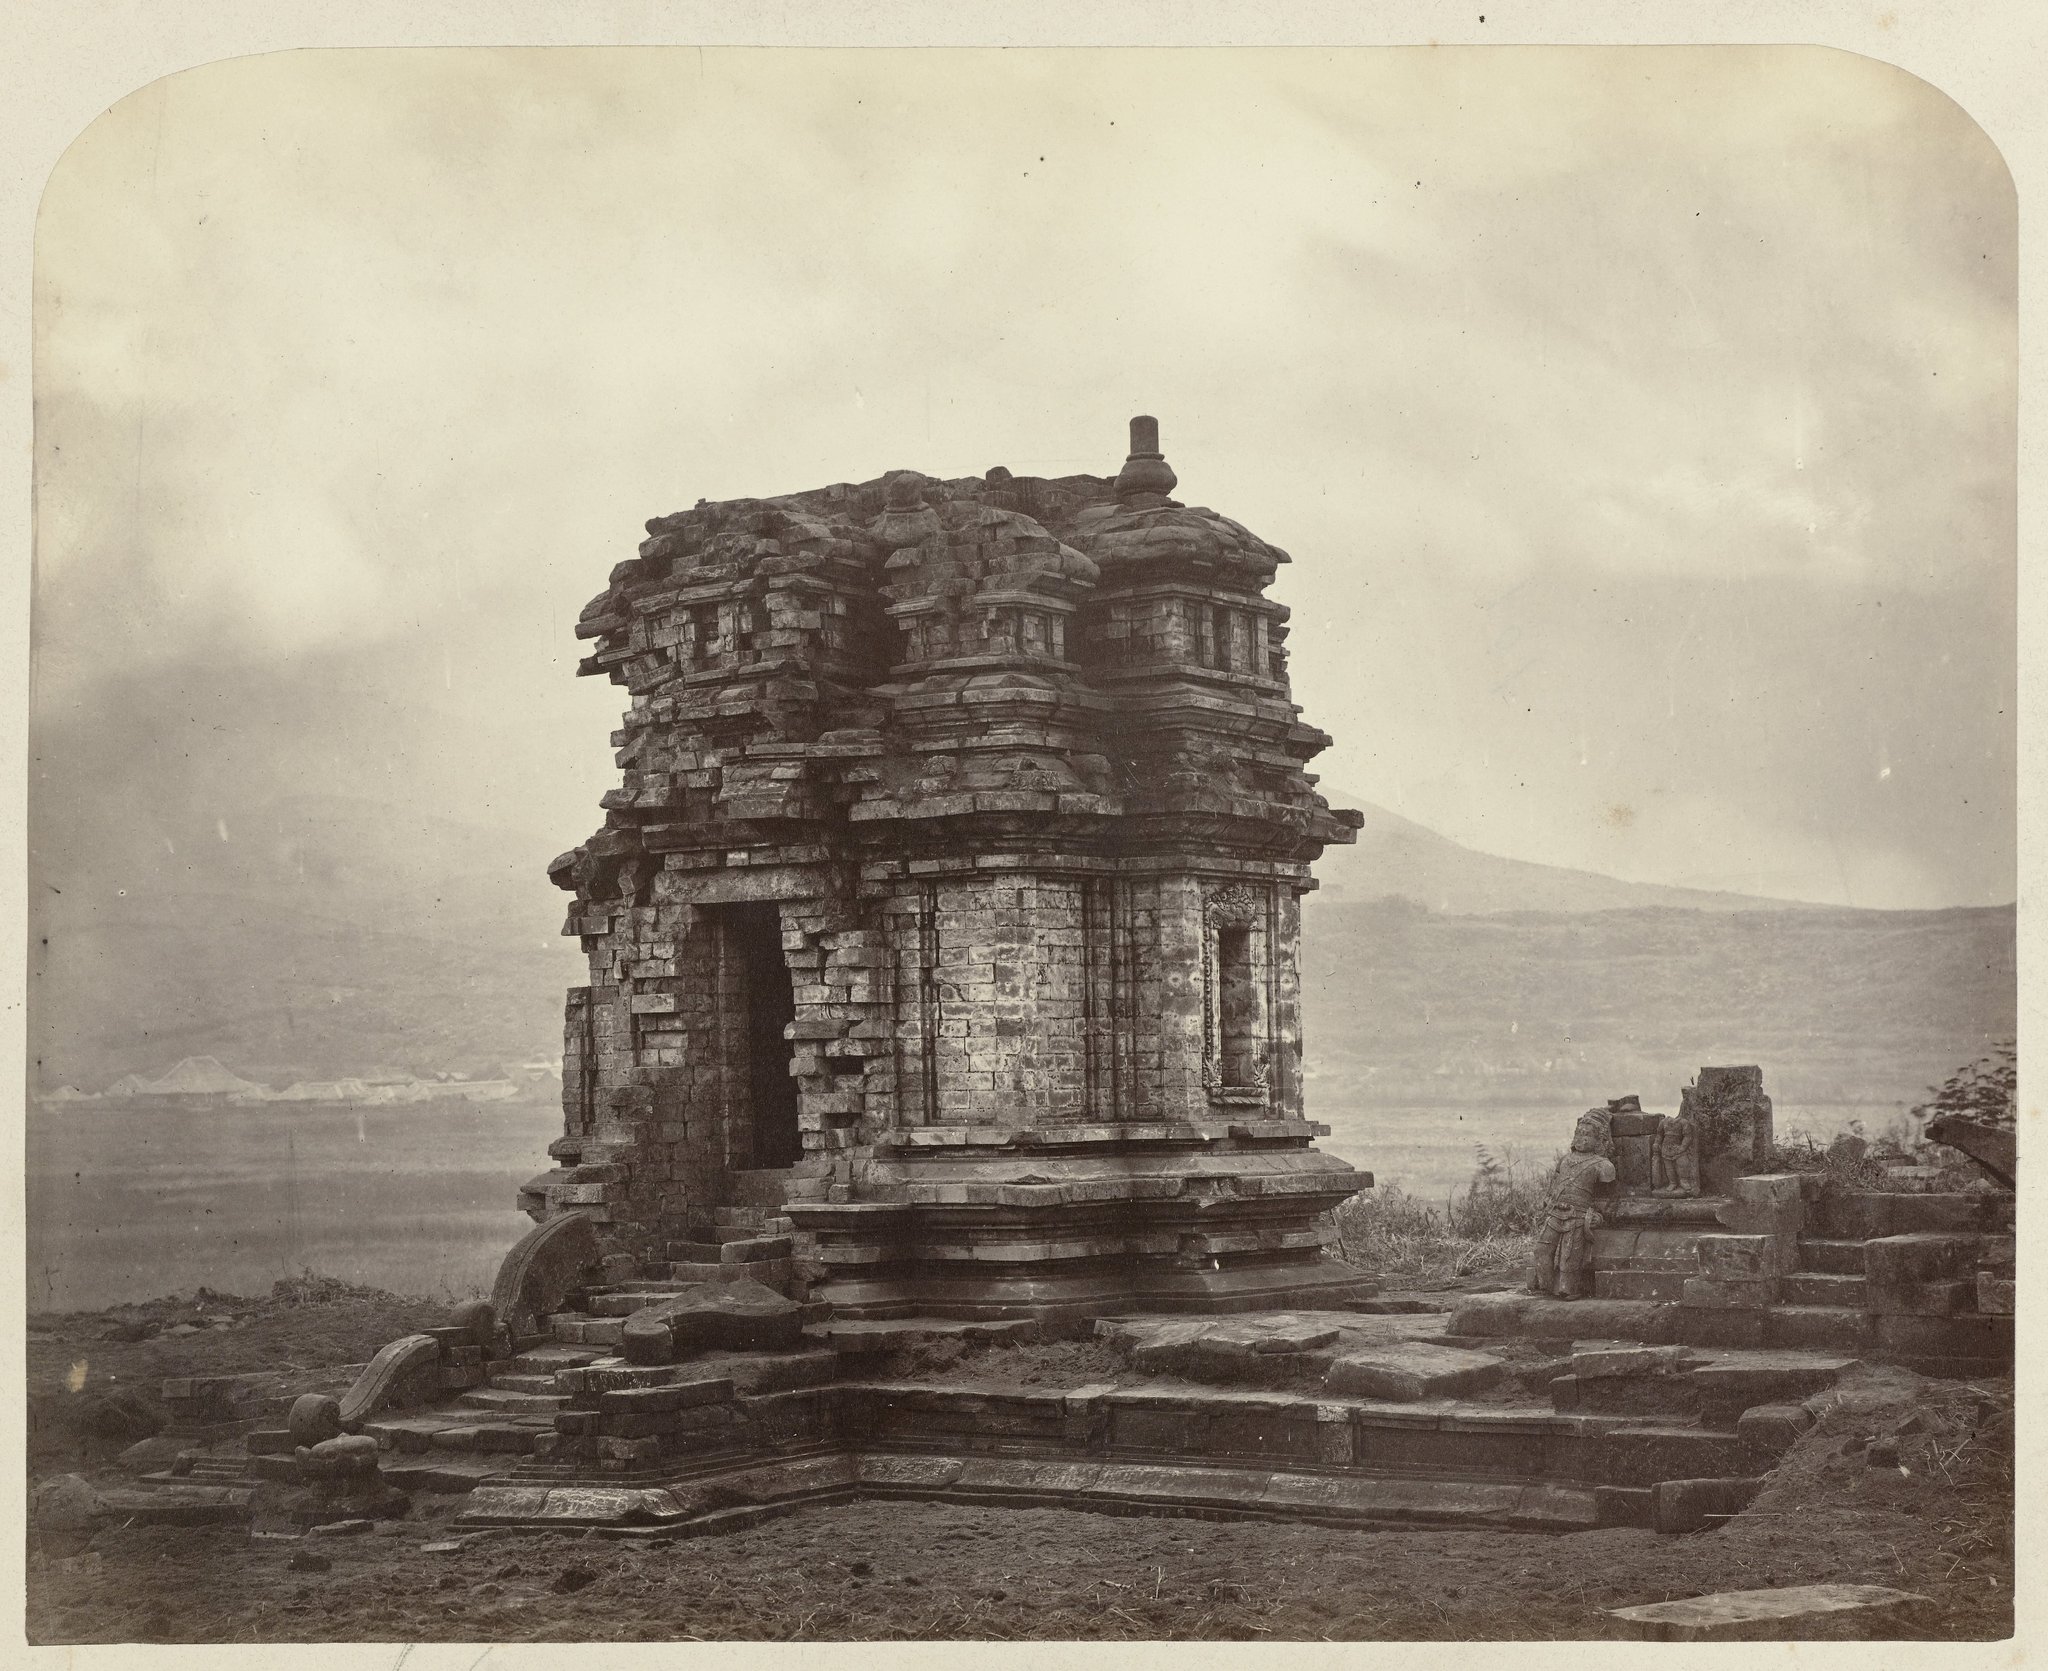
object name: photograph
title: Candi Gatotkaca, general view with staicase projection and entrance (west). Dieng plateau, Wonosobo district, central Java province 8th - 9th century.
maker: isidore kinsbergen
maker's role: fotograaf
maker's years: 1821-1905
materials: cardboard, paper, photographic support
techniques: albumen print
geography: java